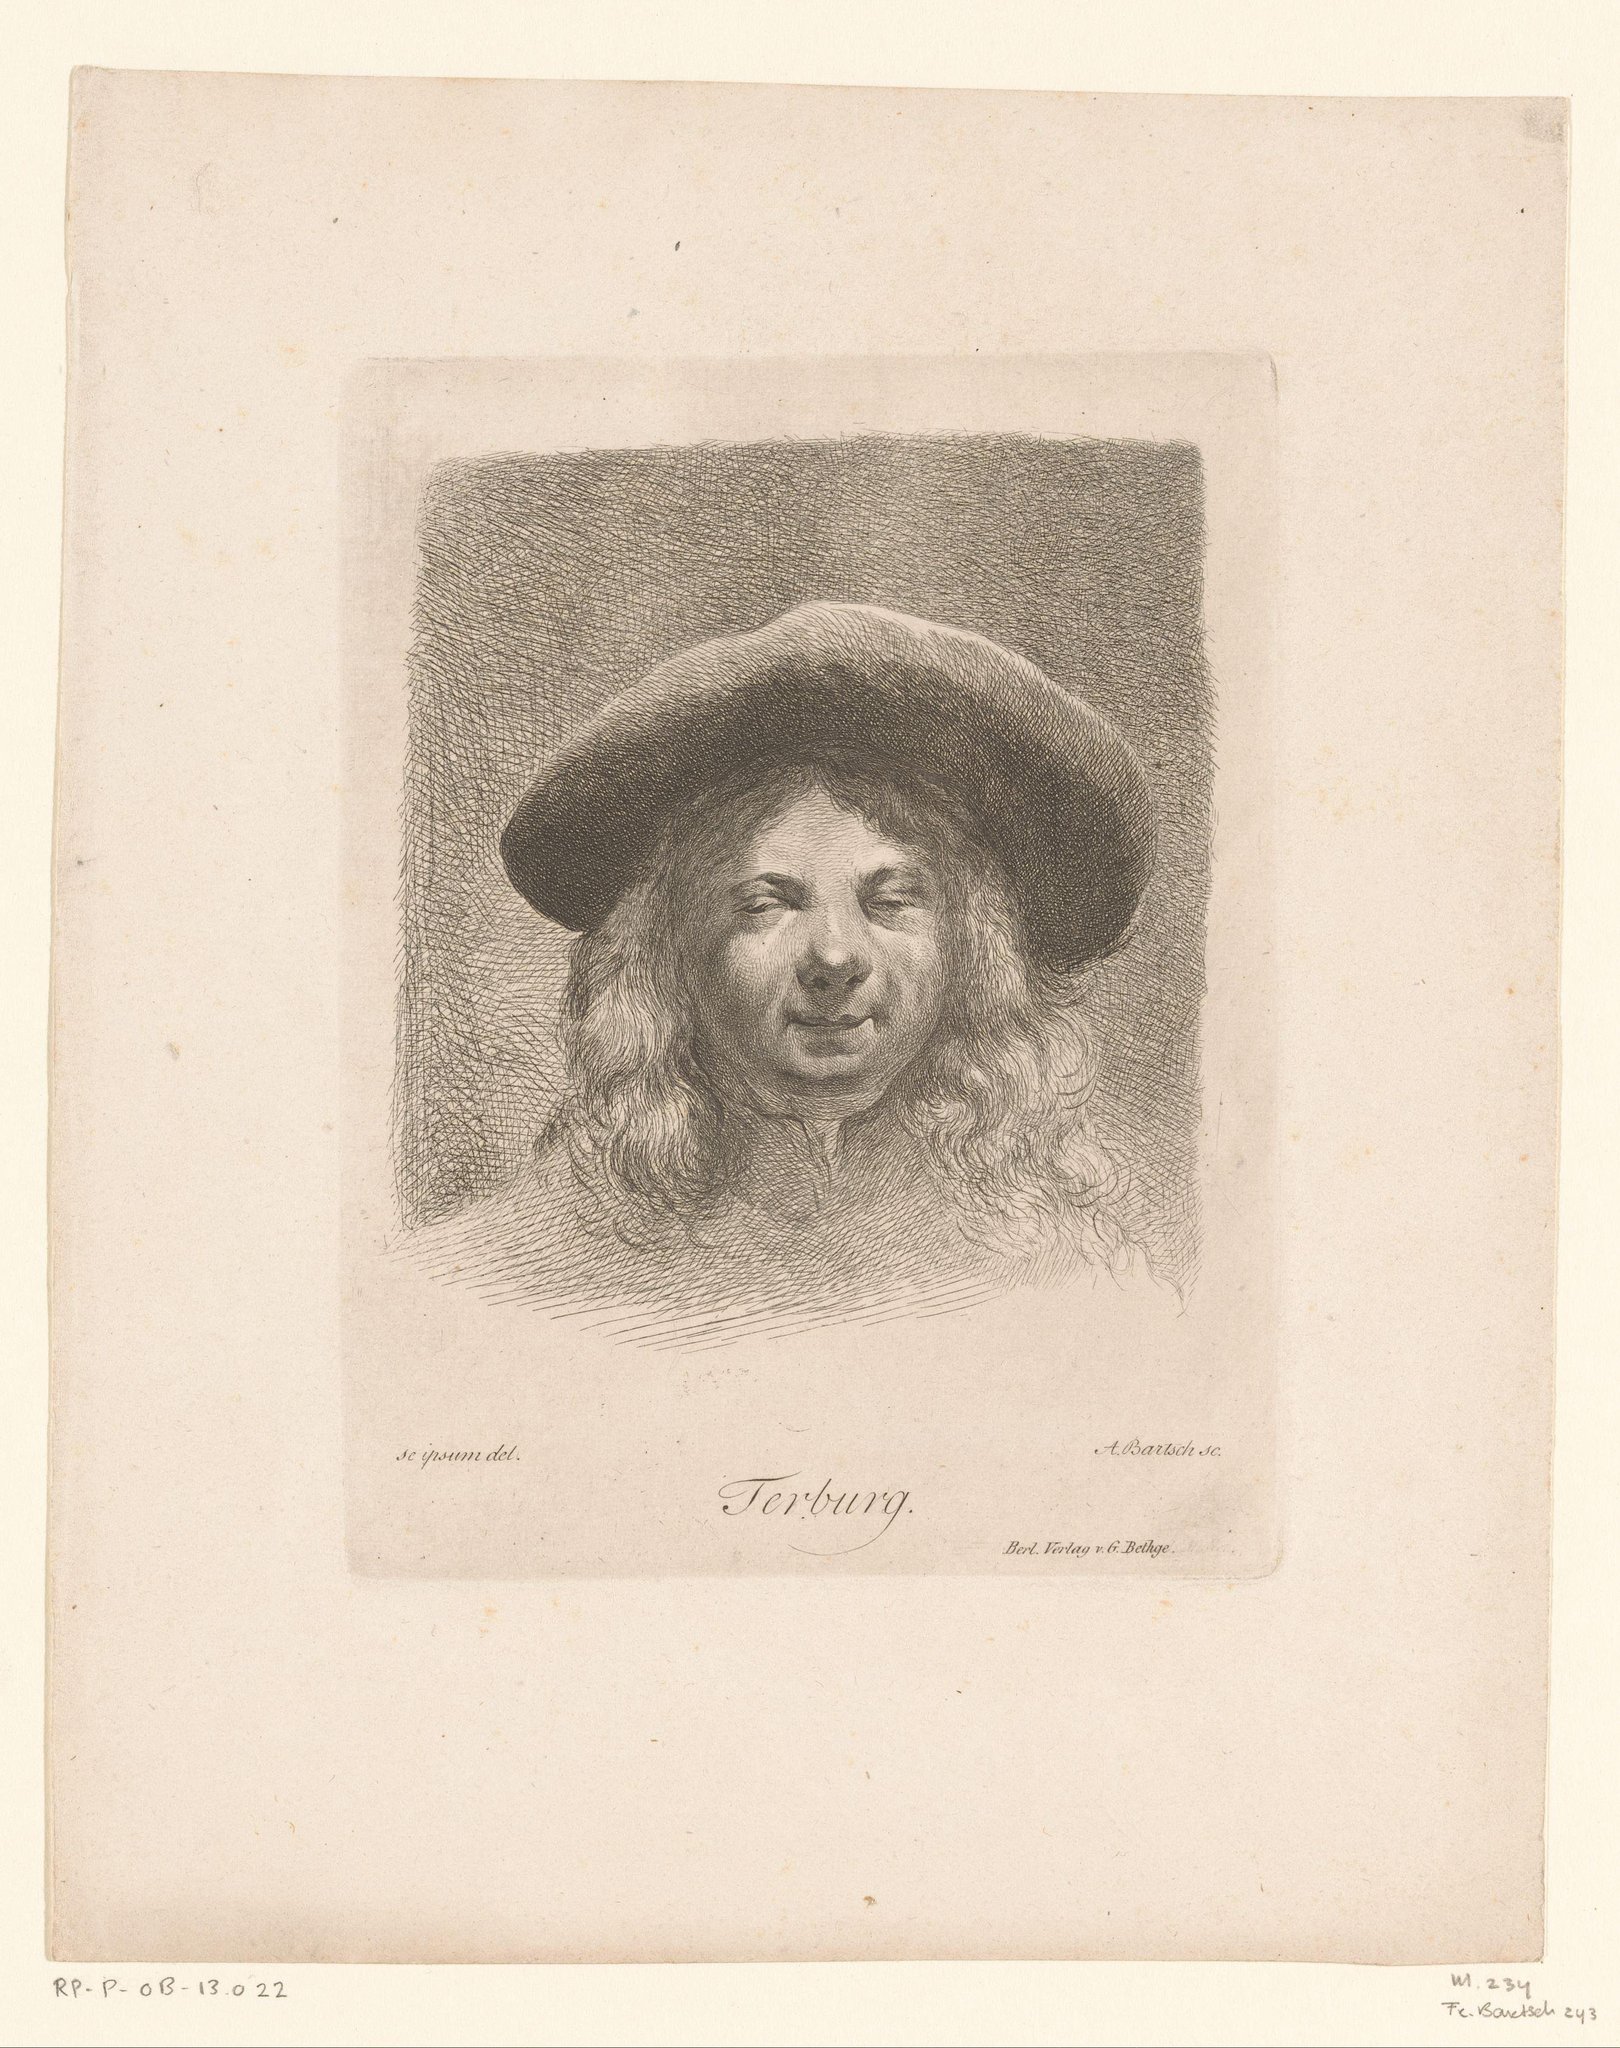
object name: print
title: Portret van Moses ter Borch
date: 1803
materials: paper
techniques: engraving, etching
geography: vienna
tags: draughtsman, moses ter borch, portrait, self-portrait of artist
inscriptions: collector's mark: Lugt 2228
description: Voorheen werd deze prent geïdentificeerd als het portret van Gerard II ter Borch.